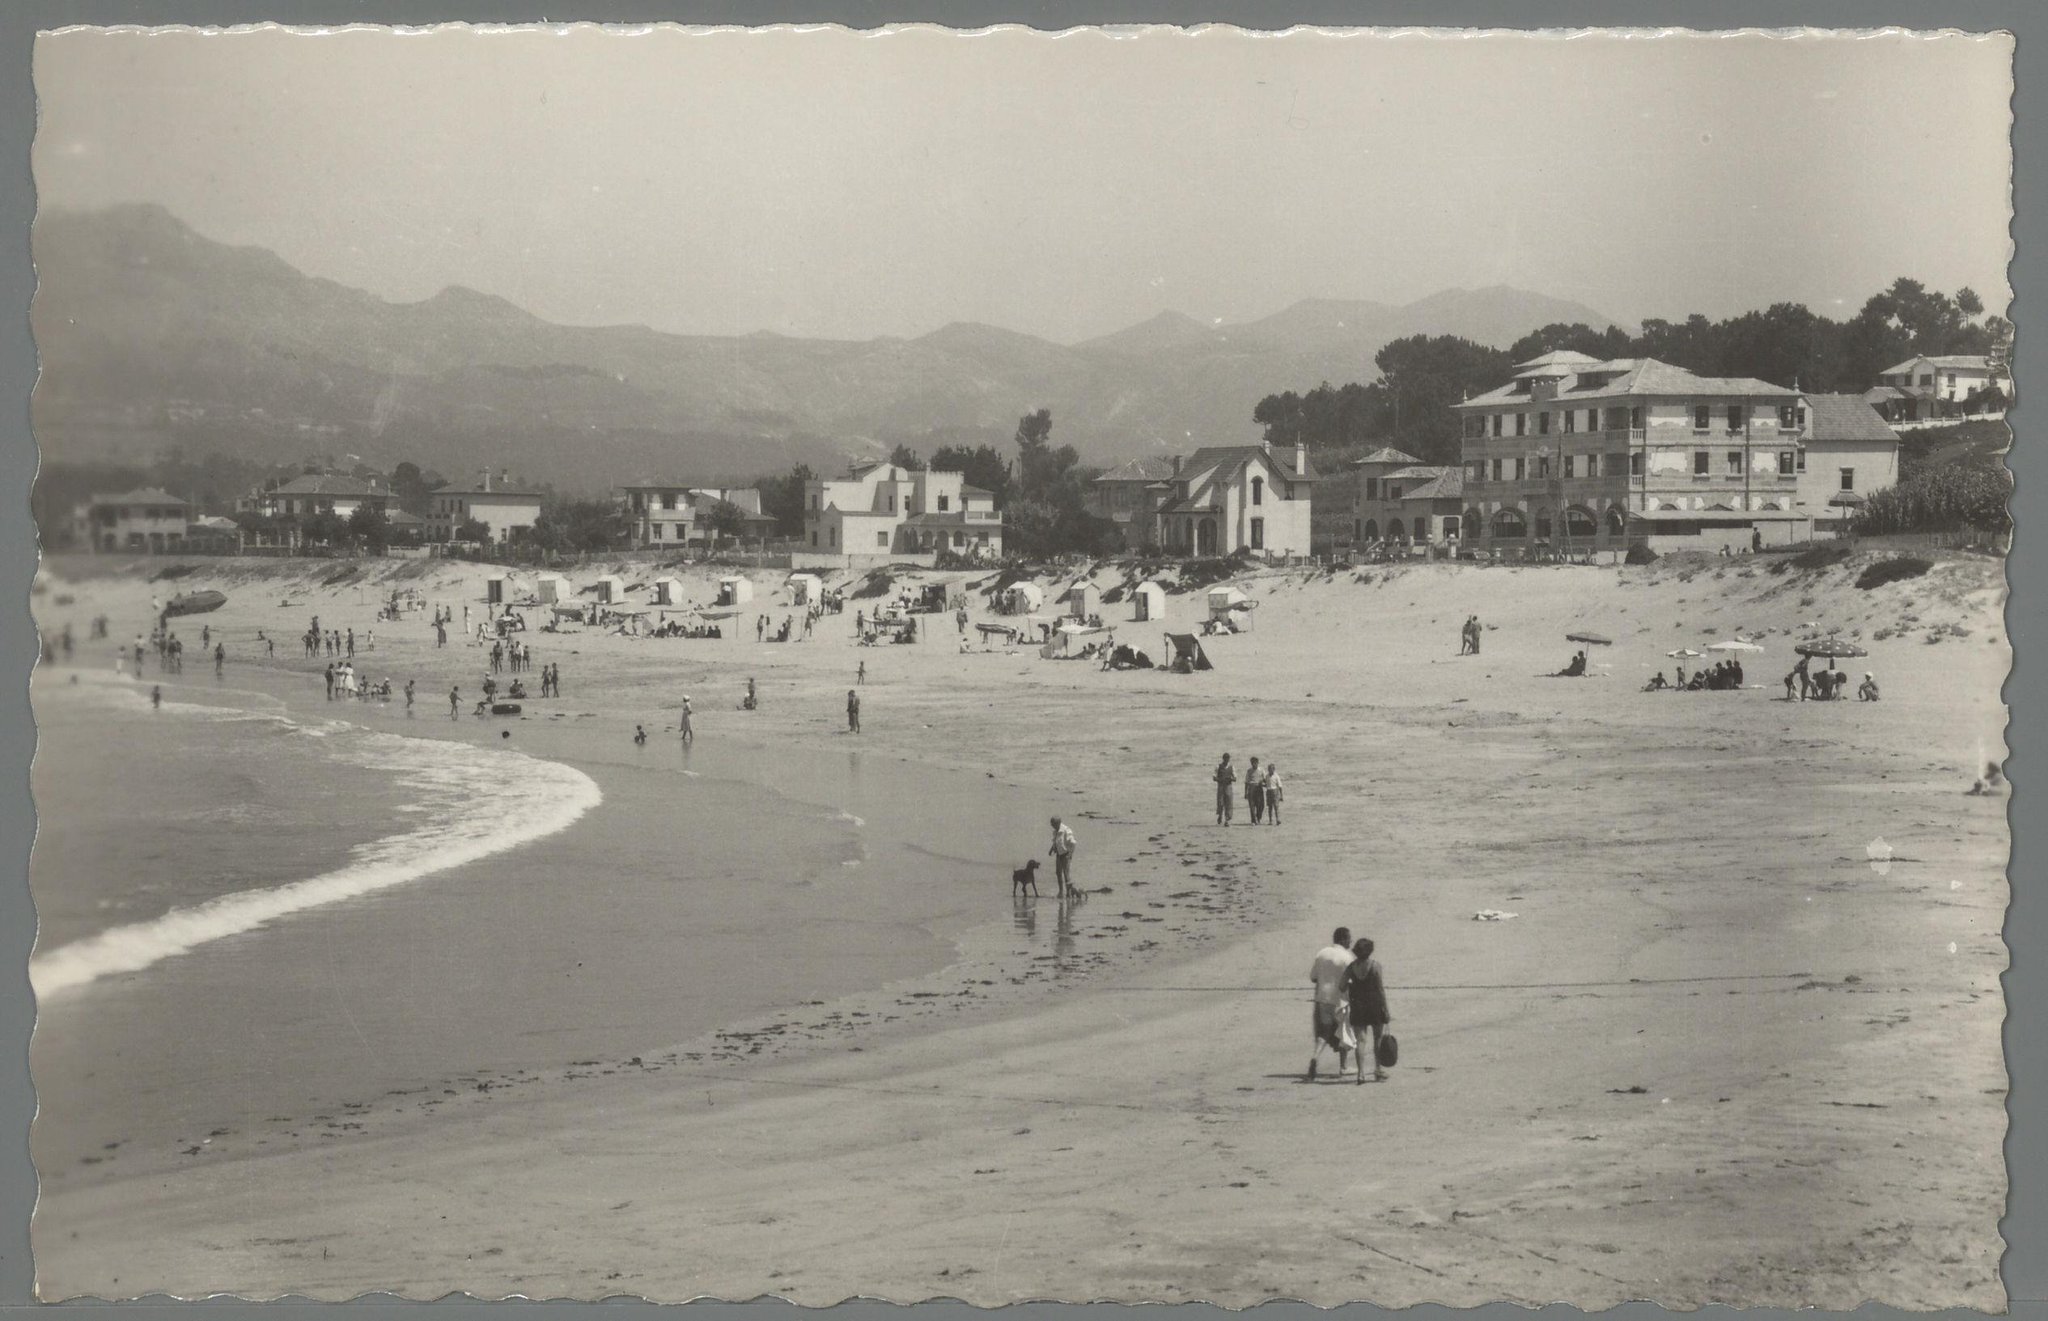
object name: photograph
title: Vigo. Playa de América / America Beach / Plage d'Amérique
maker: luis garcía garrabella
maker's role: publisher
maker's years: -1977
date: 1939-1950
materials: photographic support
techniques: photography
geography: vigo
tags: beach (as place of recreation), prospect of city, town panorama, silhouette of city (+ city(-scape) with figures, staffage)